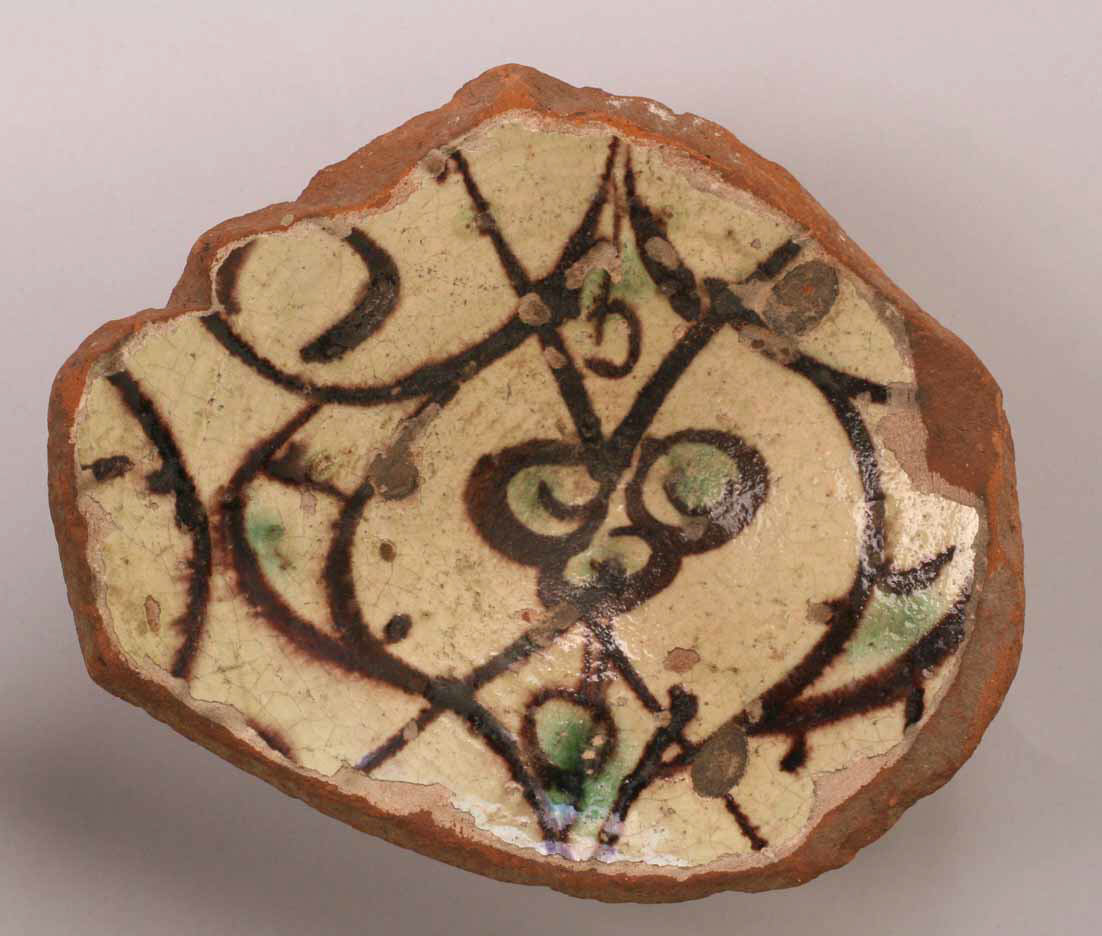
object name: fragment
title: Fragment of a Bowl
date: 1301-1500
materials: earthenware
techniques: glazing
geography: egypt